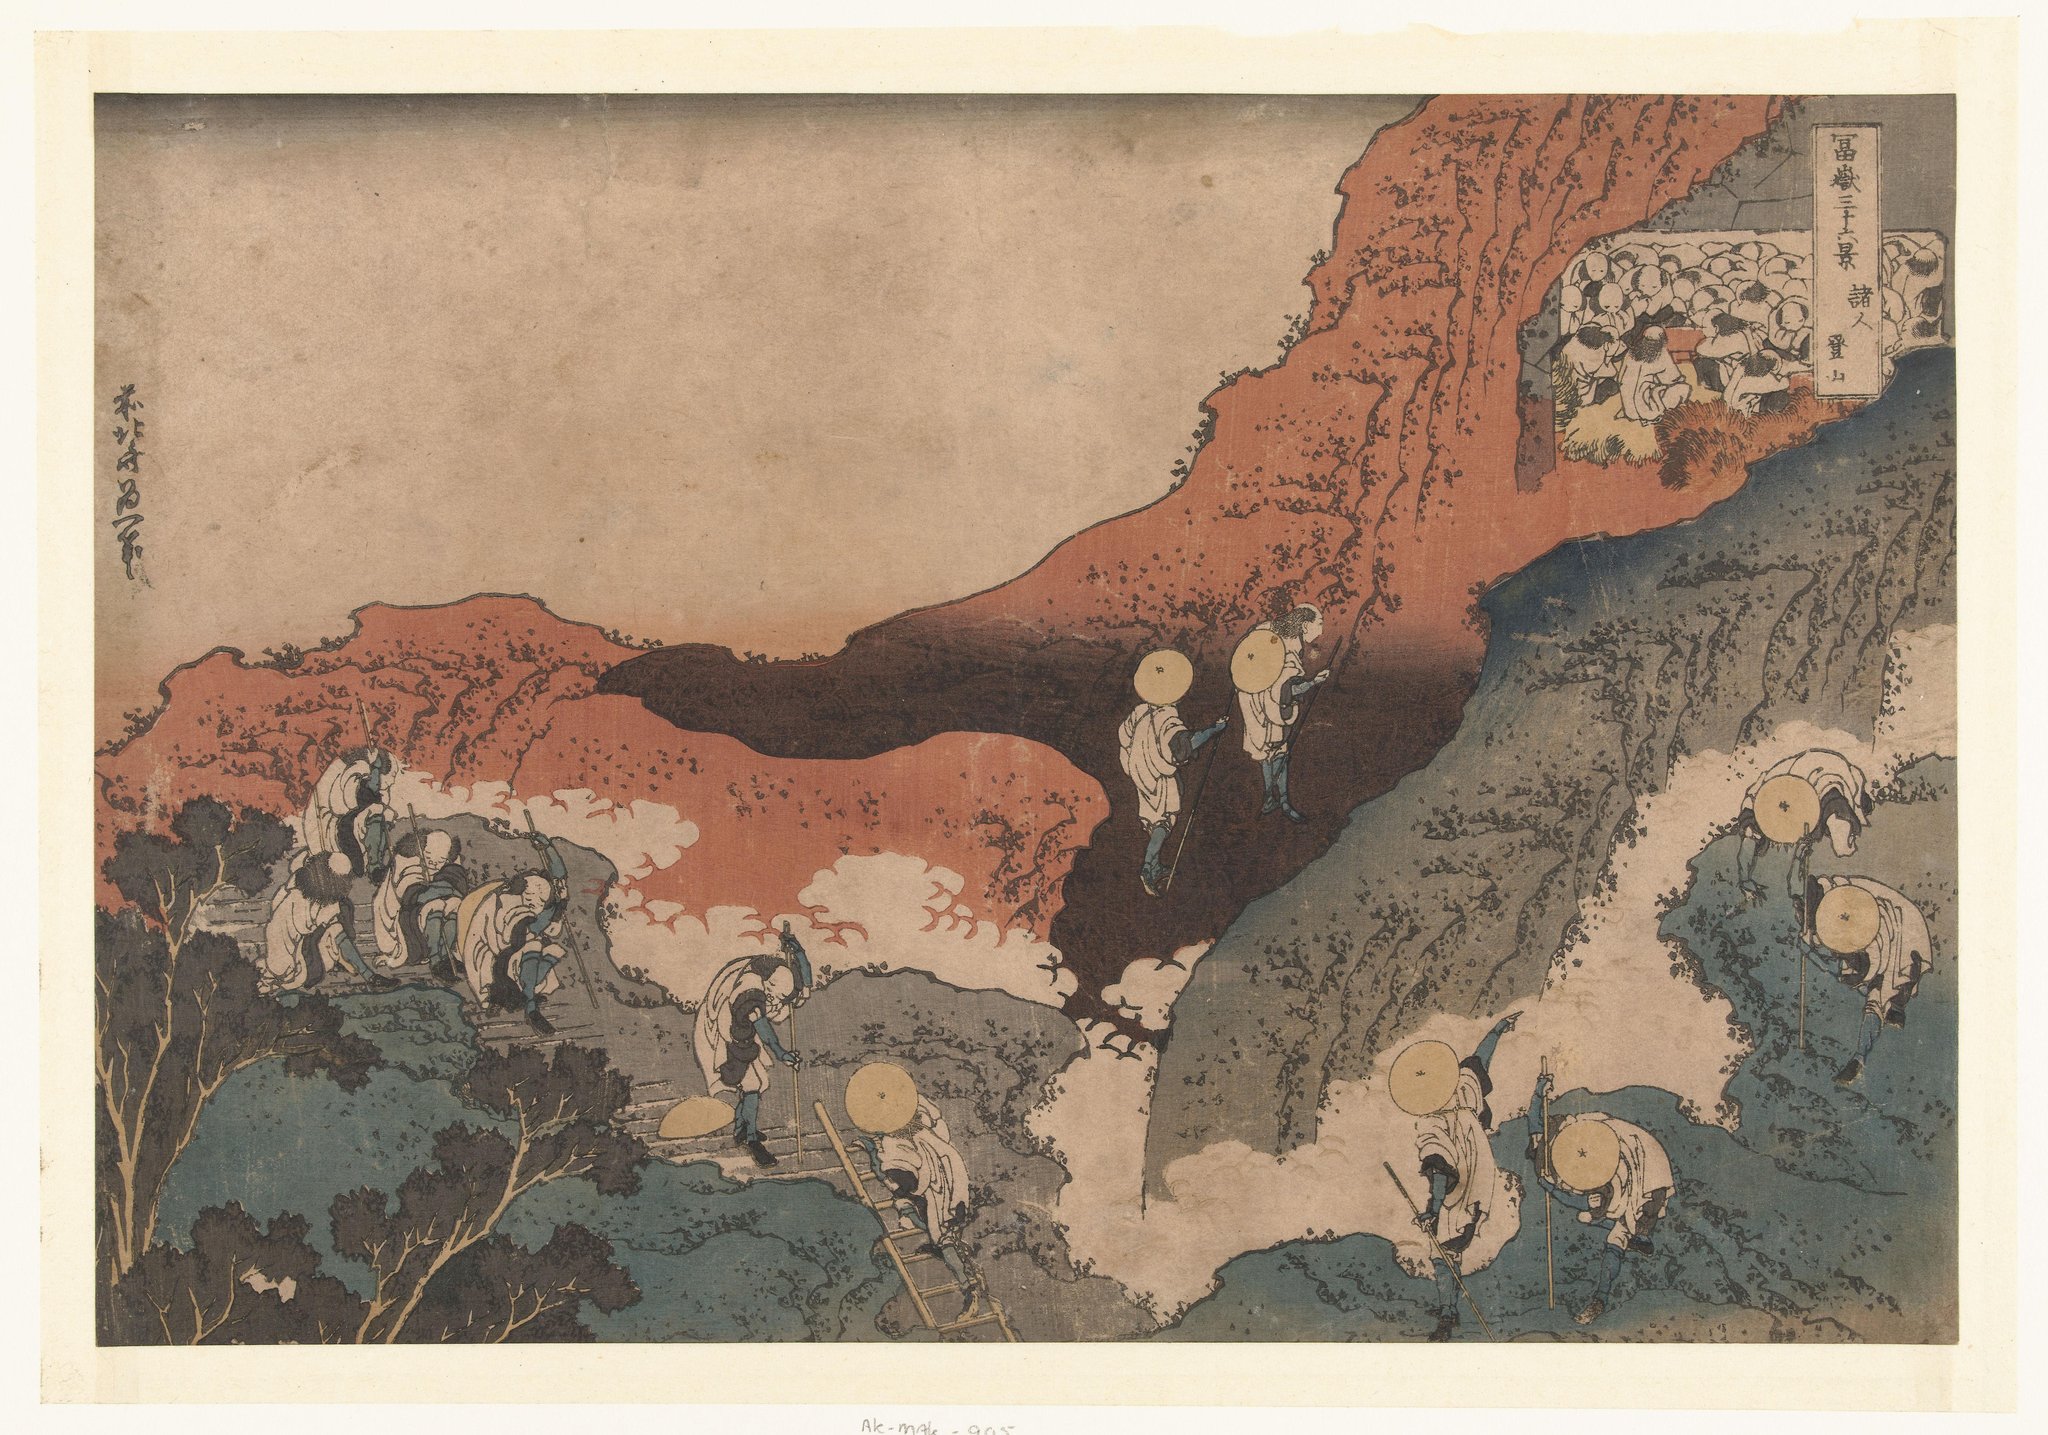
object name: print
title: Bergbeklimmers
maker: katsushika hokusai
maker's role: draughtsman, print maker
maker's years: 1760-1849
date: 1831-1835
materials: paper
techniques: woodcut, nishiki e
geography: japan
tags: mountain climbing, mountaineering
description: Pelgrims in witte kleding de berg Fuji beklimmend; rechtsboven verschillende pelgrims in een grot.